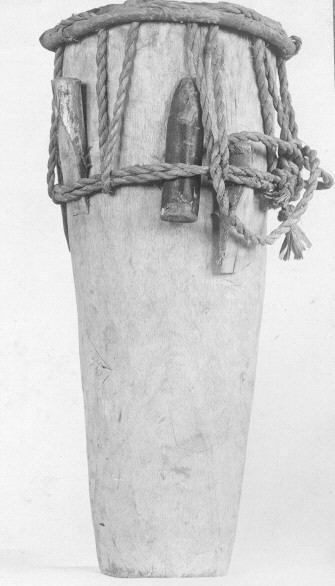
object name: drum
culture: native american or guyanese or demerara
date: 1801-1900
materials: skin, wood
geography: guyana